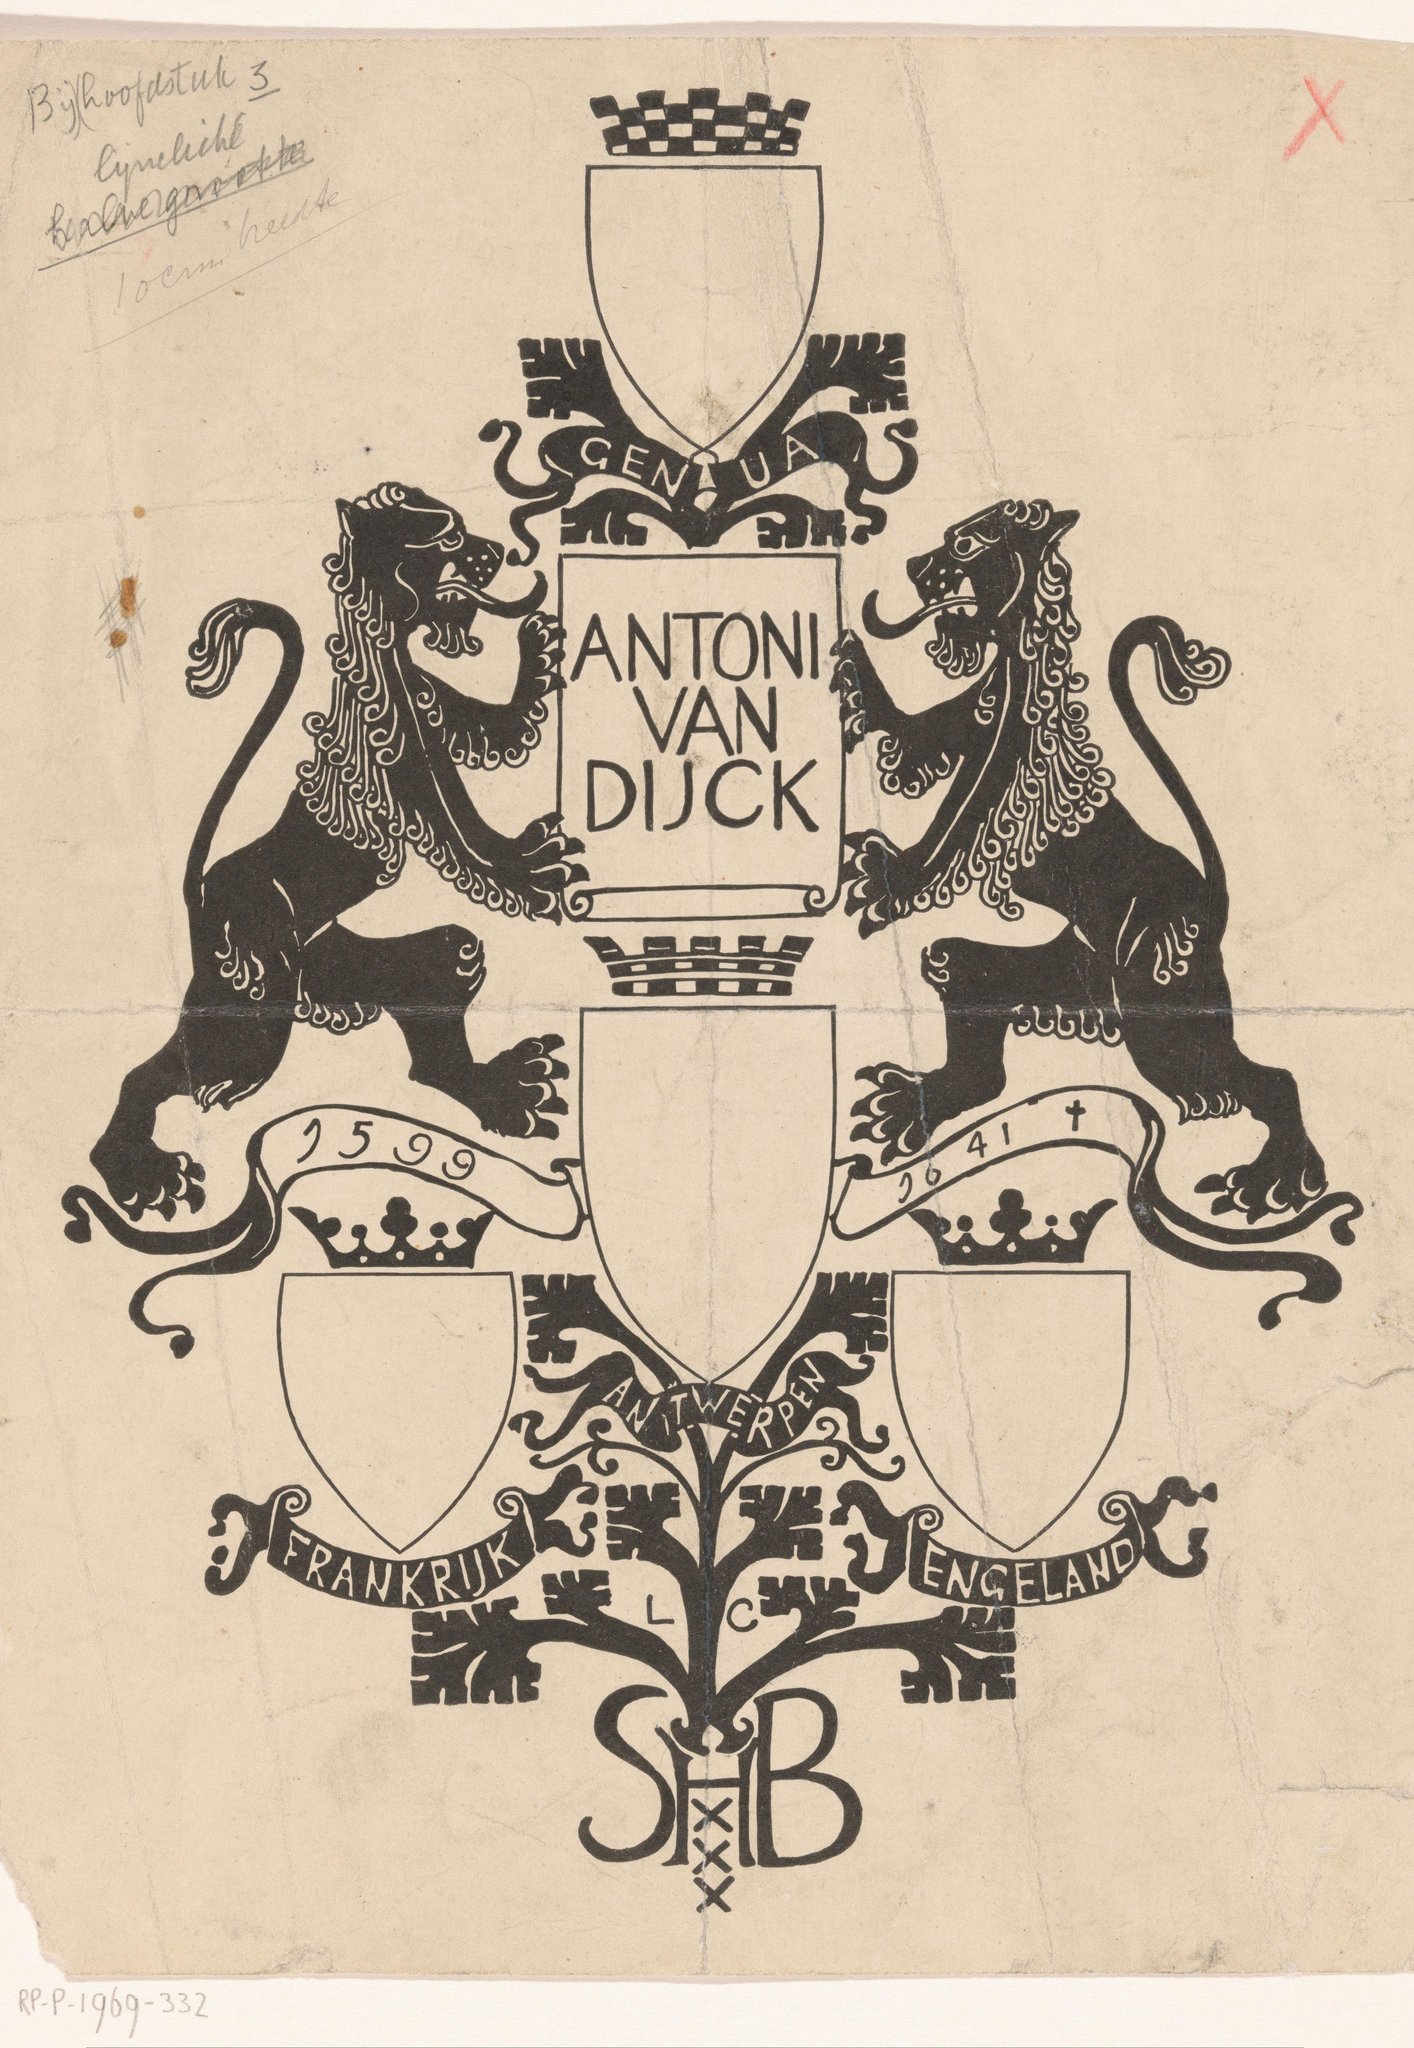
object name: print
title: Bandontwerp voor: M.C. Nieuwbarn, Antoon van Dijck: de mensch en de meester, twintig photogravures naar zijne meest beroemde werken, 1903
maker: carel adolph lion cachet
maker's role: draughtsman, print maker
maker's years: 1864-1945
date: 1904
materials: paper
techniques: line block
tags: antwerp, london, painter, print maker, draughtsman, anthony van dyck, coat of arms (as symbol of the state, etc.), ornament derived from animal forms, beasts of prey, predatory animals: lion, france, england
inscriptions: annotation: ‘Bij hoofdstuk 3. halve grootte [doorgekrast]. lijncliché. 10 cm breed’, collector's mark: Lugt 2228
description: Twee leeuwen houden een uitgerold blad vast waarop 'Antoni van Dijck' staat. Onderaan drie lege wapenschilden met daaronder de plaatsen Frankrijk, Antwerpen en Engeland. Bovenaan een leeg wapenschild met eronder Genua.